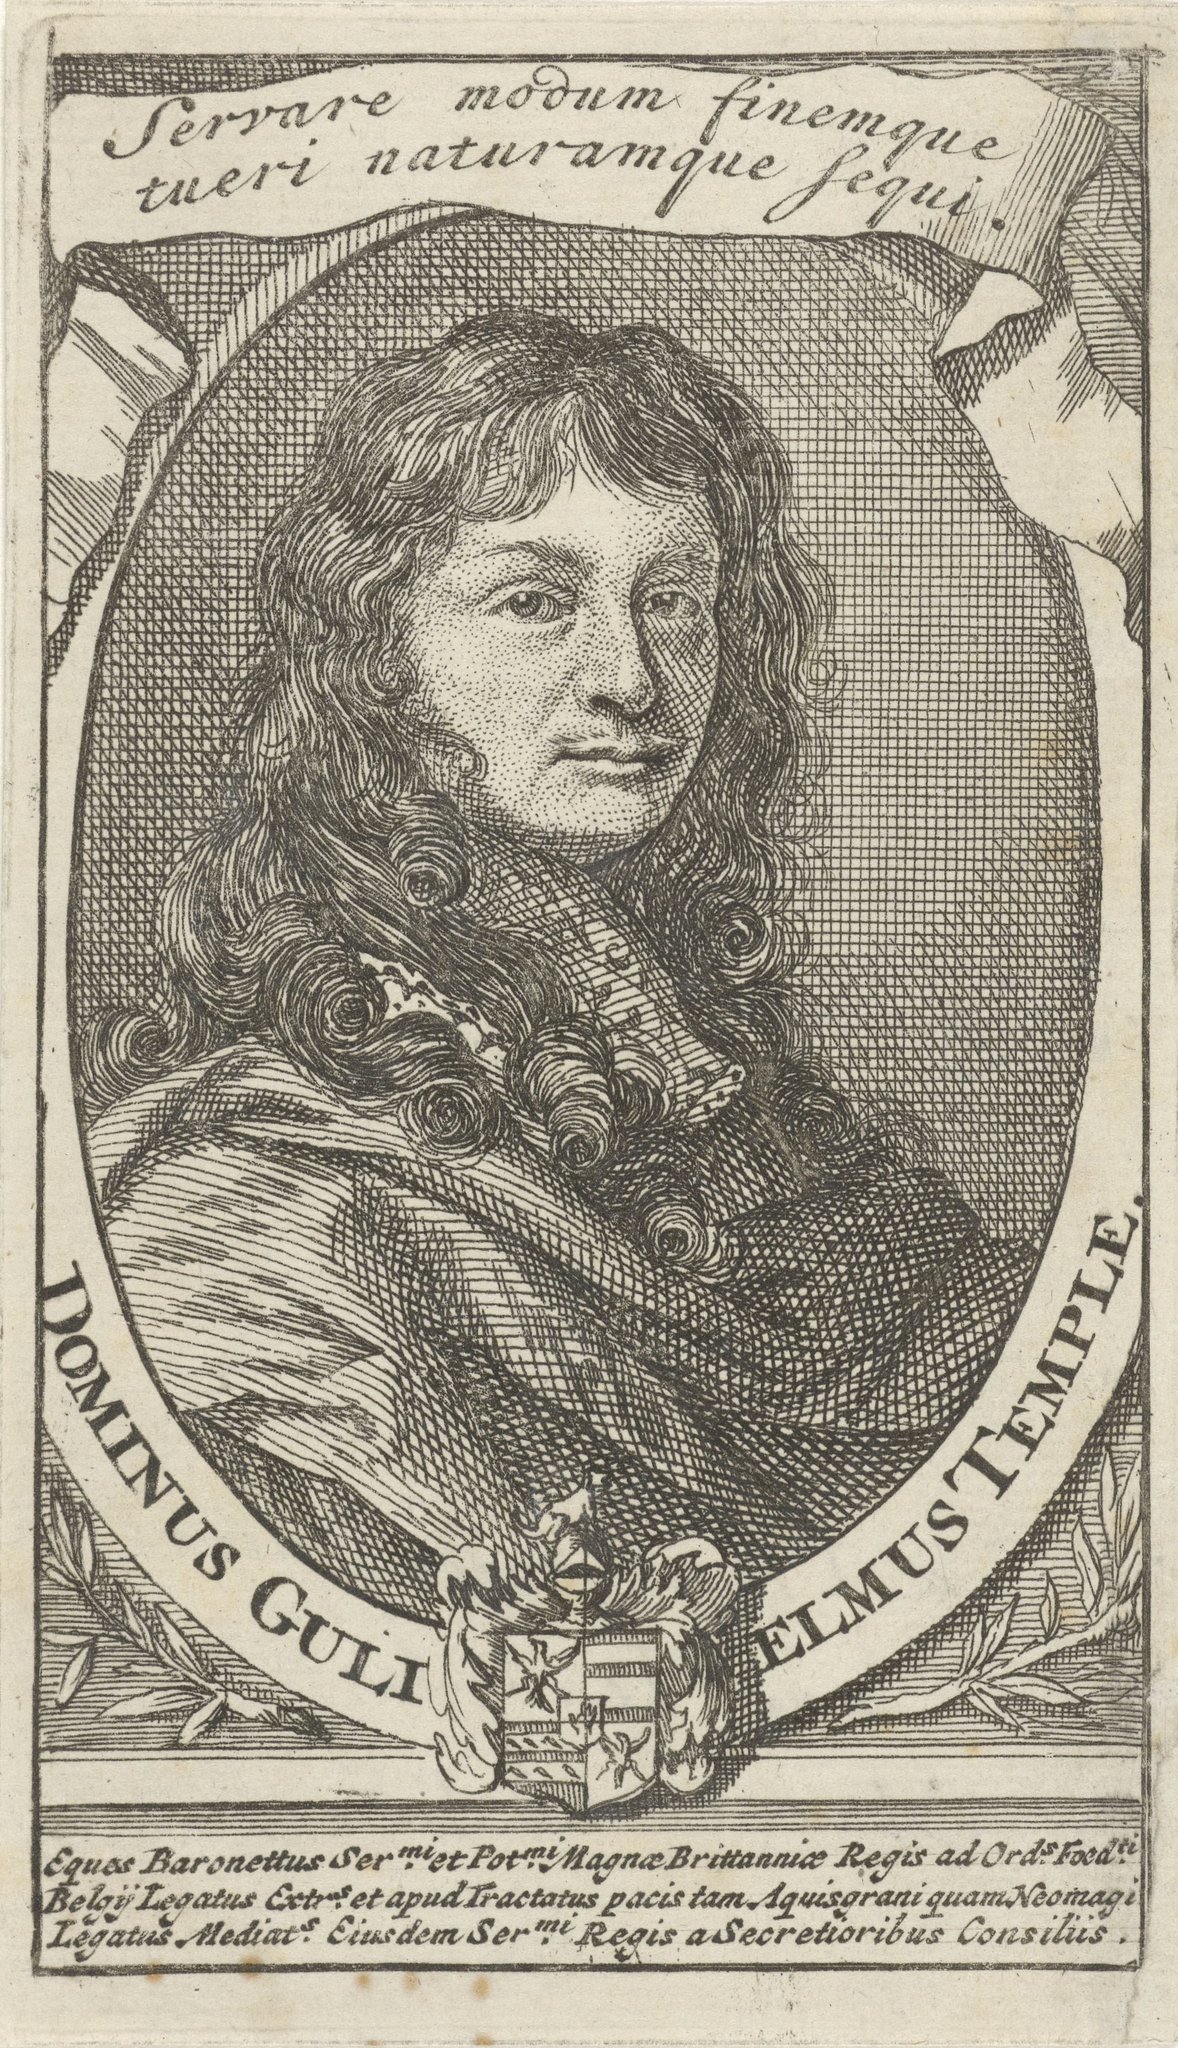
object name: print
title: Portret van William Temple, staatsman en diplomaat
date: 1695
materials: paper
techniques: etching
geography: amsterdam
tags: essayist, william temple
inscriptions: collector's mark: Lugt 2228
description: Illustratie uit: Temple, William. Introduction a l'histoire d'Angleterre. Amsterdam: Jean Louis de Lorme, 1695.